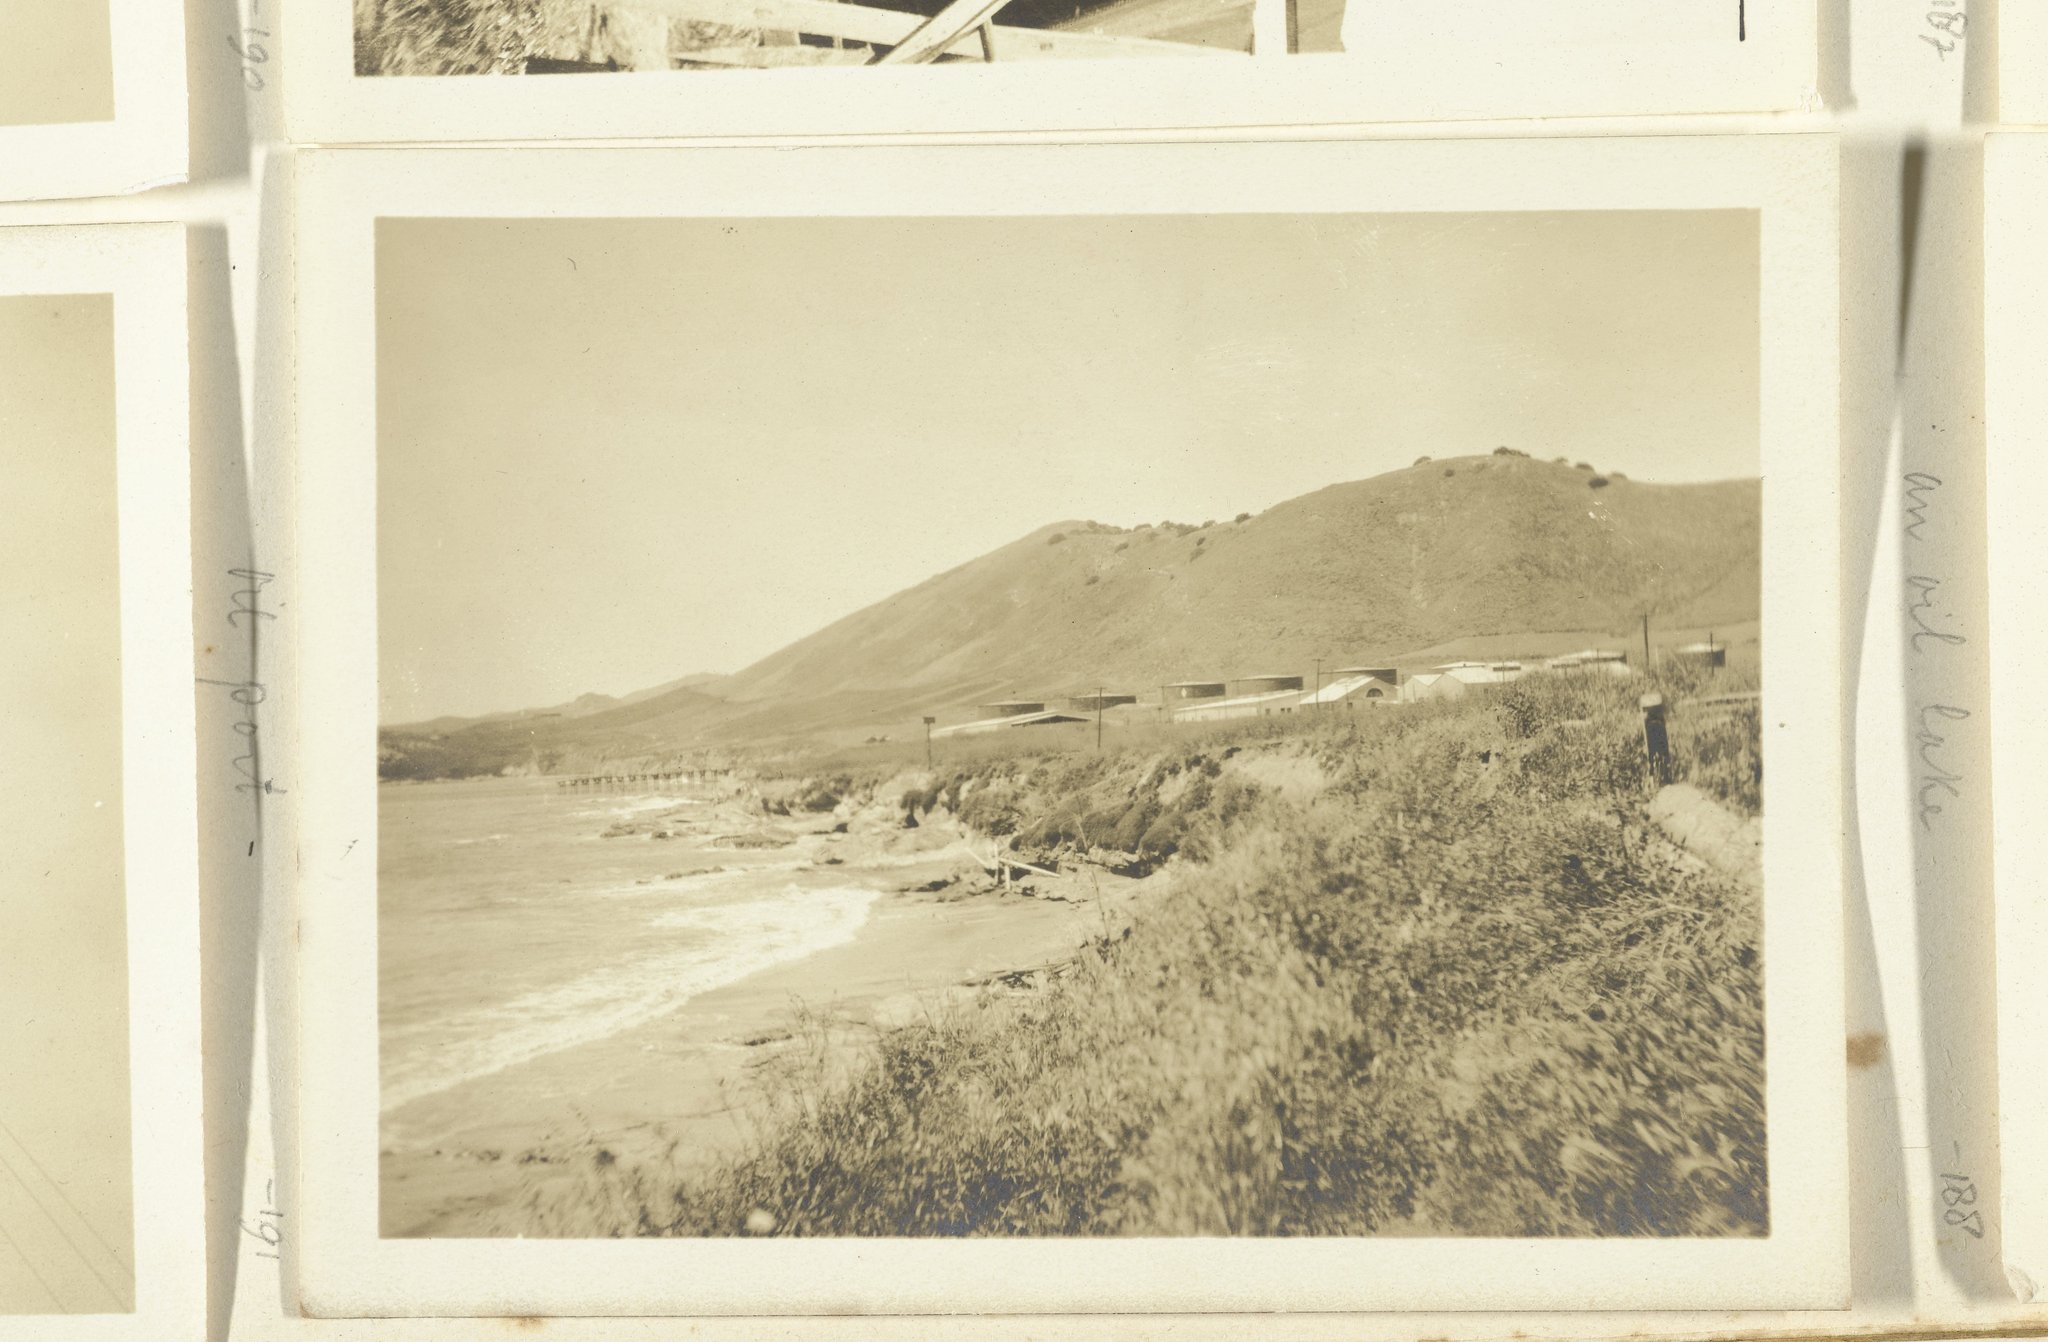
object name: photograph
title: Visit to an Oil Field in Purissima Hills, USA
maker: geldolph adriaan kessler (dolph)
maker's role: fotograaf, industrieel, voetballer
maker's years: 1884-1945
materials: cardboard, photographic support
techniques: gelatin silver print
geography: california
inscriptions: title: ‘Oil port’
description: In 1908 Kessler accompanied the director of Koninklijke Olie (Royal Dutch Petroleum Company, later Shell), Henri Deterding, as secretary on a world tour. He travelled to Canada and the United States via the Dutch East Indies, Singapore, China, and Japan. Dolph’s photo album contains pictures of an oil field in California, as well as San Francisco’s town hall which had collapsed during an earthquake.